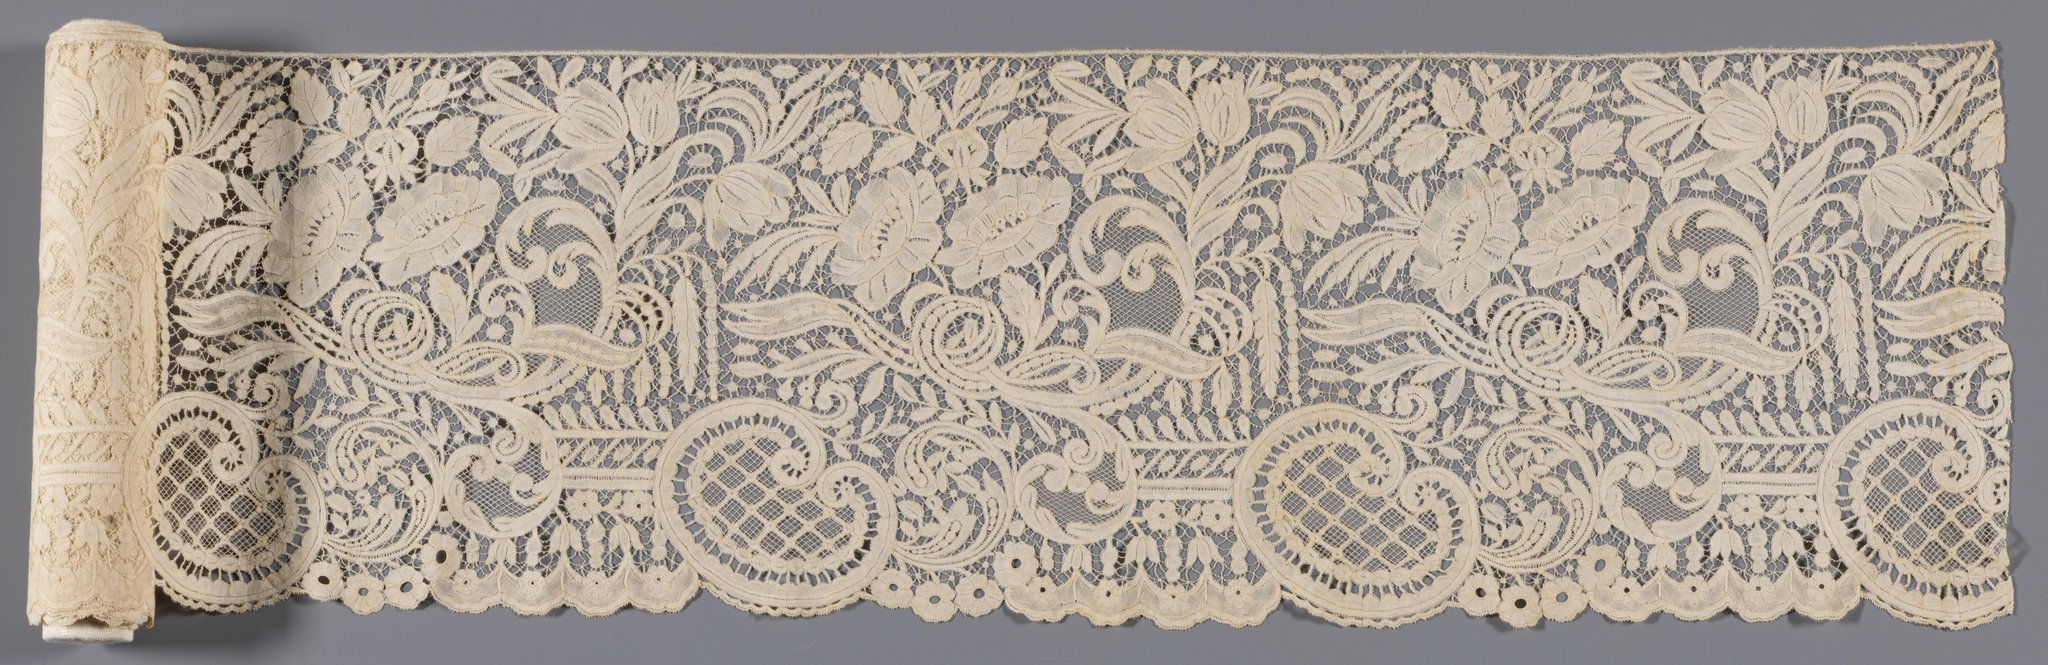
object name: womenswear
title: Japonstrook van kloskant, met een geschulpte rand, versierd met niervormige cartouches met vulpatroon, een sierband, ranken, kleine bloemen, krullende linten, rozen en tulpen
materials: lace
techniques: lace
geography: ghent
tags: bruges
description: Japonstrook van kloskant: Gentse kant. Met een geschulpte rand, versierd met niervormige cartouches met vulpatroon, een sierband, ranken, kleine bloemen, krullende linten, rozen en tulpen. Het ontwerp voor het patroon bevindt zich nog bij de Zusters van O. L. Vrouw van de Visitatie, evenals een rekening-afschrift van 22 maart 1862 voor mevrouw de Nève voor geleverde kant. Het kant werd gedragen door mevrouw Irma Jeanne Constance Marie Ghislaine de Nève de Roden, op 27-06-1865 gehuwd met Paul Maximilien Ghislain, baron van Caloen de Basseghem, voor haar portret, in 1865 geschilderd door Fritz Hickmann (1820-1900; part. verz. België).